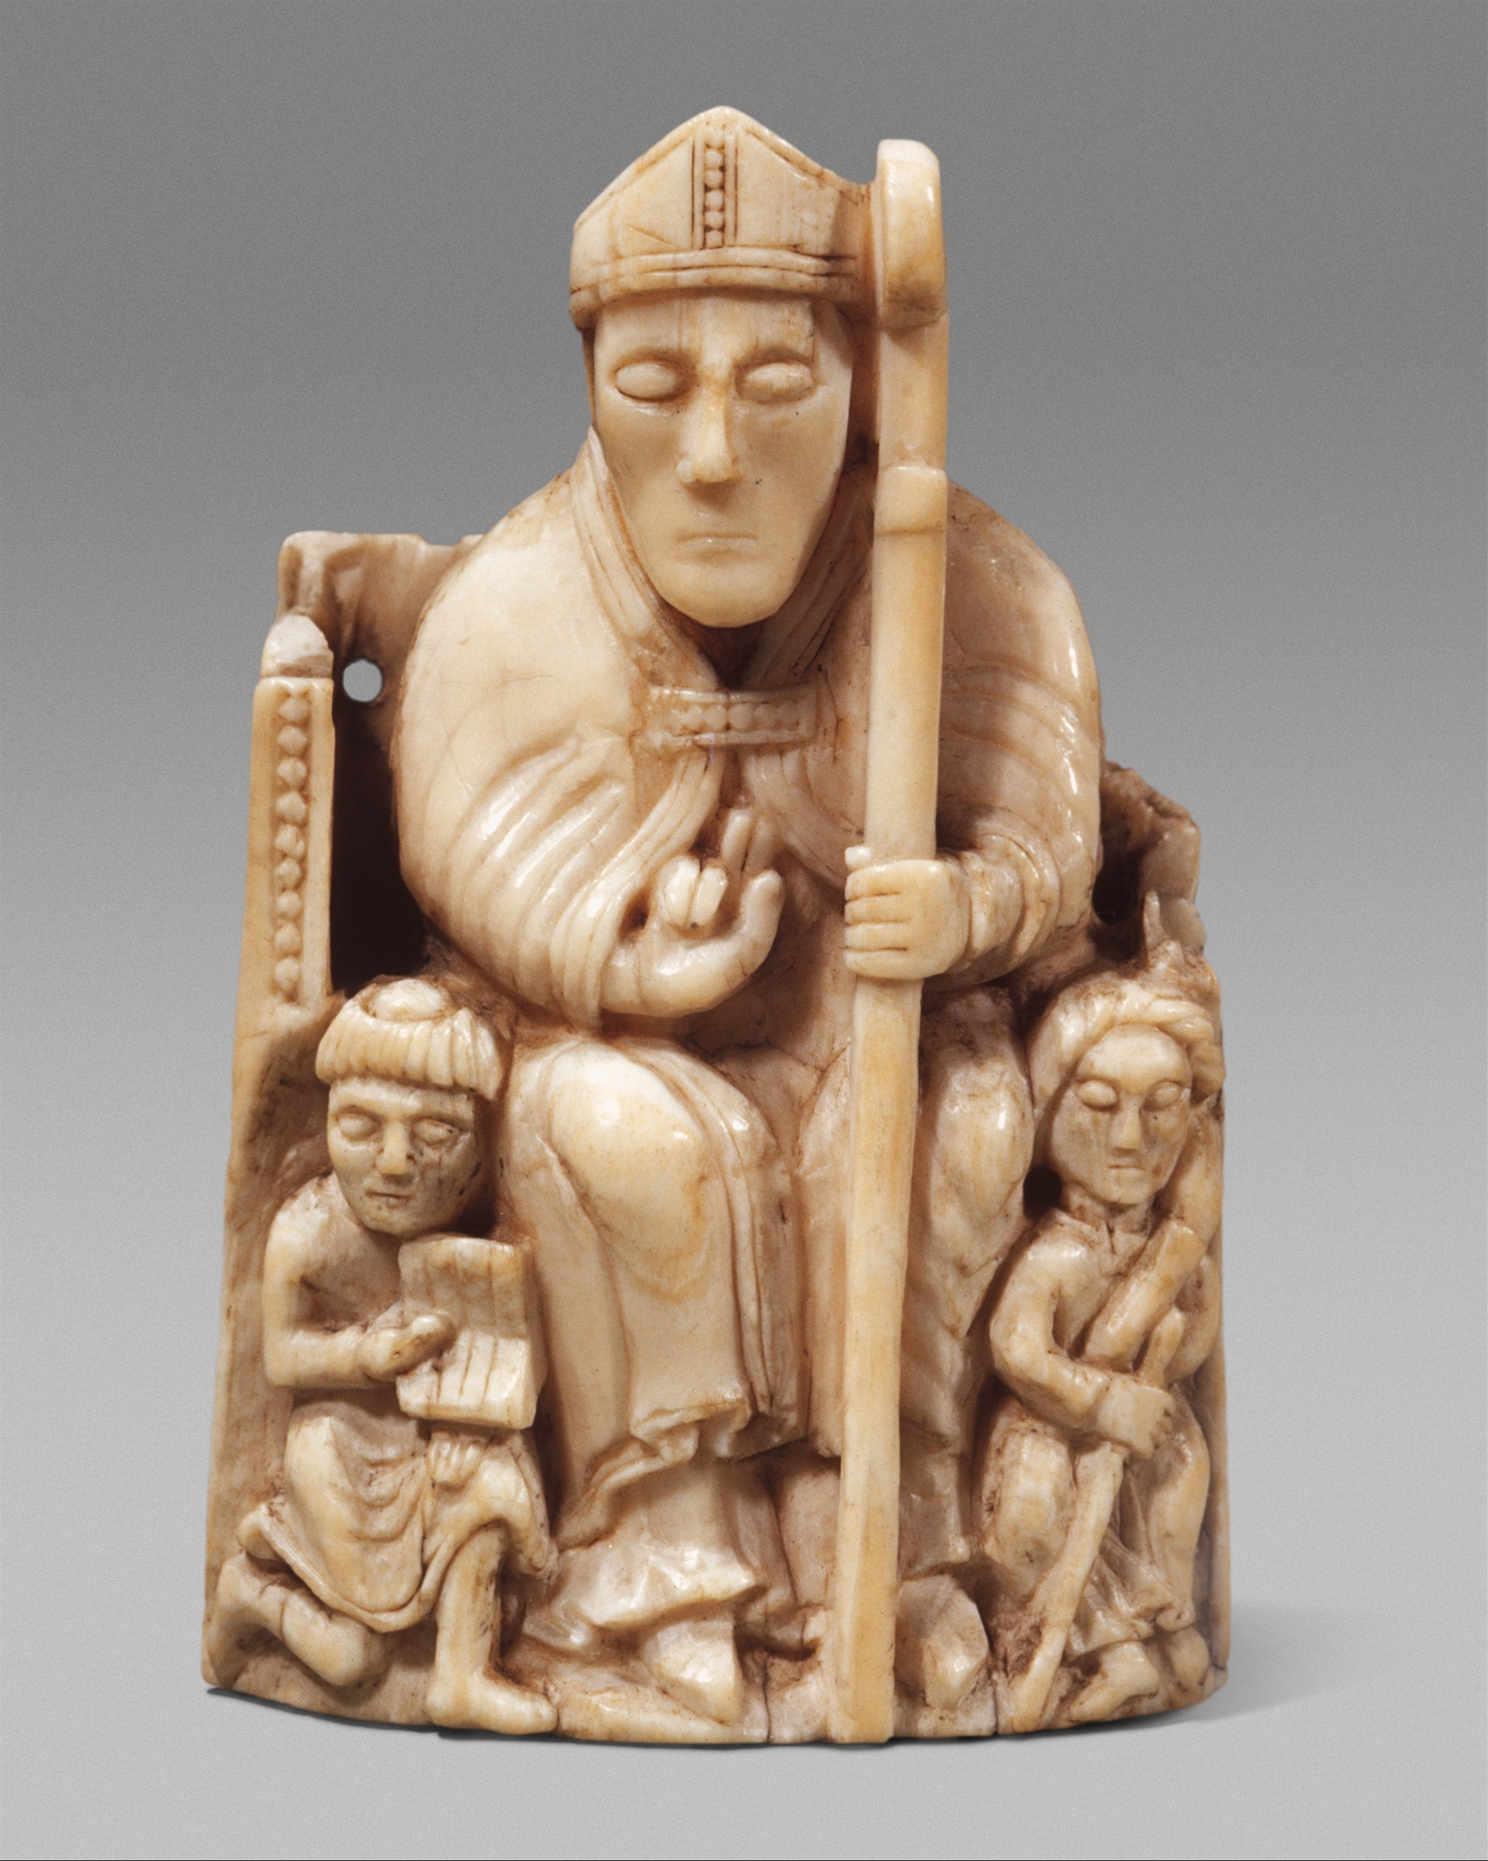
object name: chess piece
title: Bishop Chess Piece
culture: scandinavian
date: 1150-1200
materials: ivory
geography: norway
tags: men,chess,bishops,games